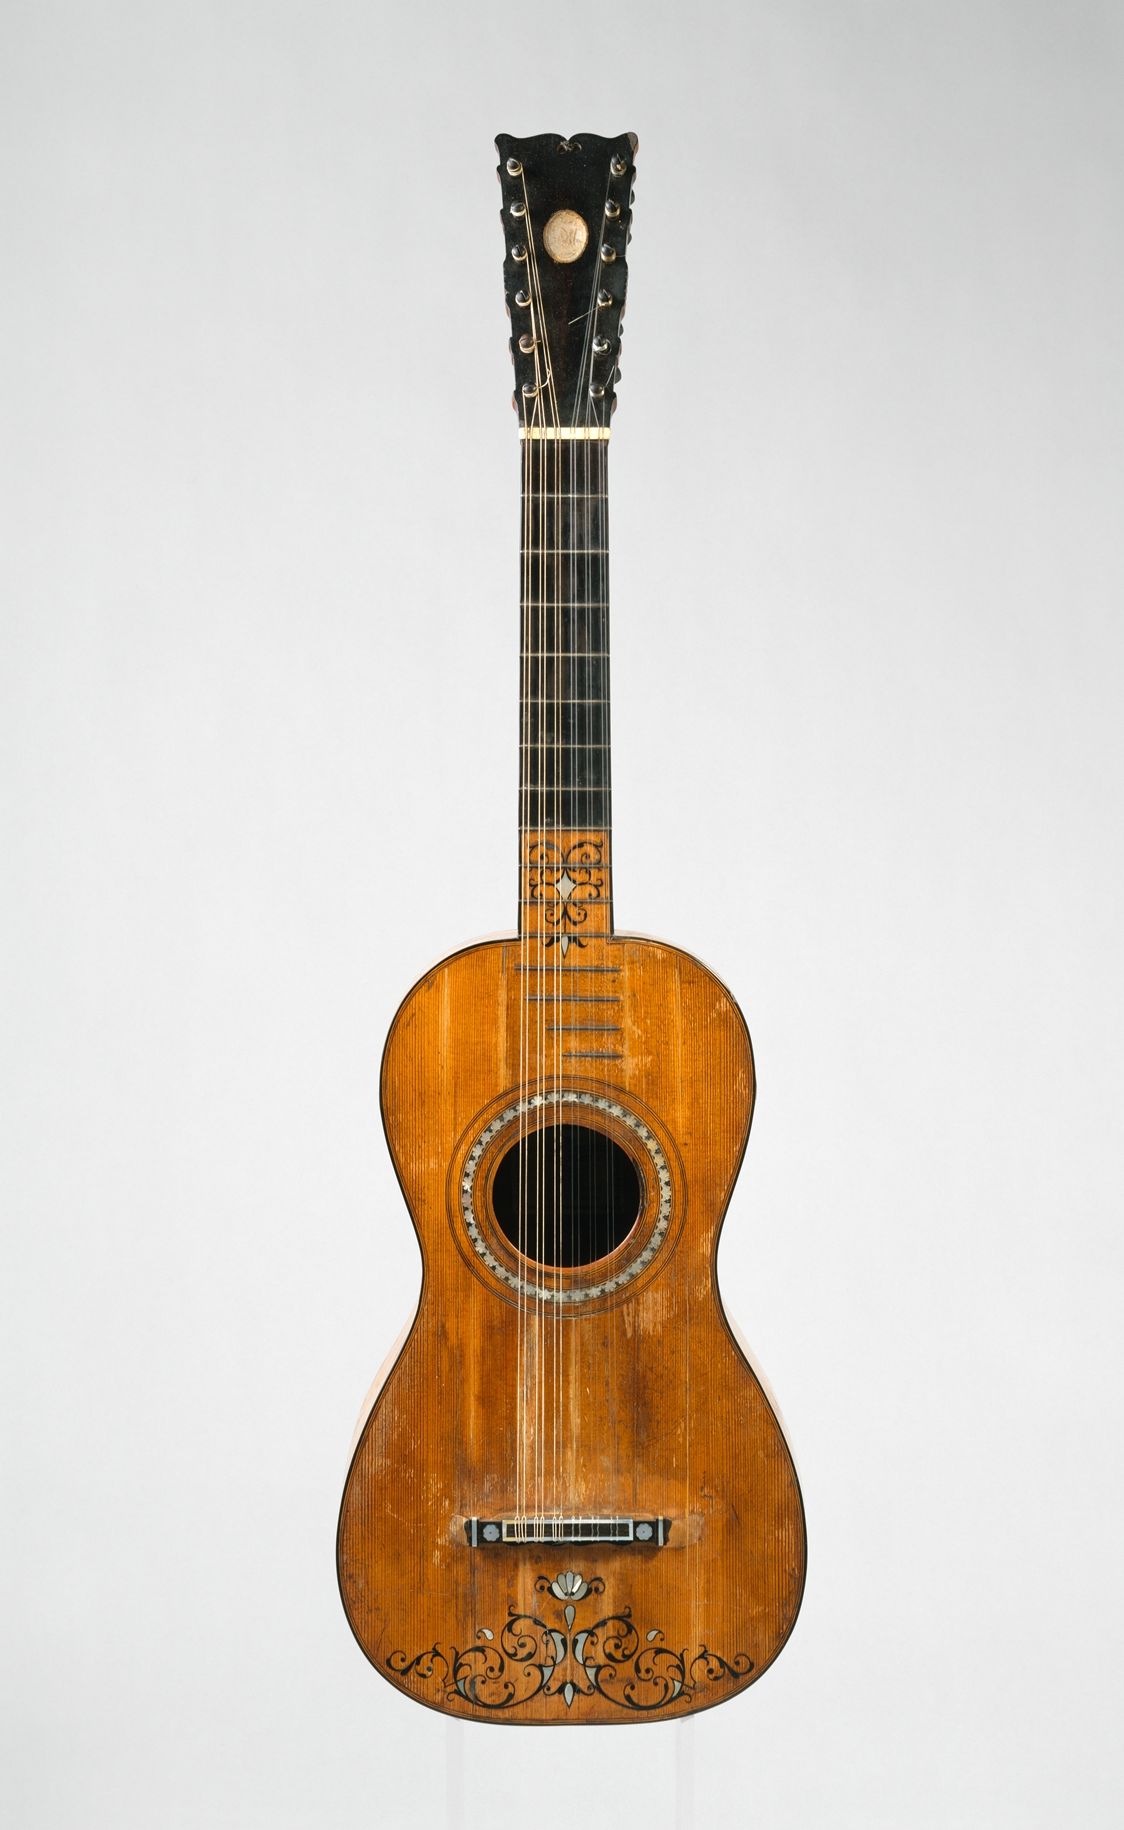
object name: guitar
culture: spanish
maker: joseph benedid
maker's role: maker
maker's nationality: spanish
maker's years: 1760-1836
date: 1787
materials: bone, wood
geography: spain